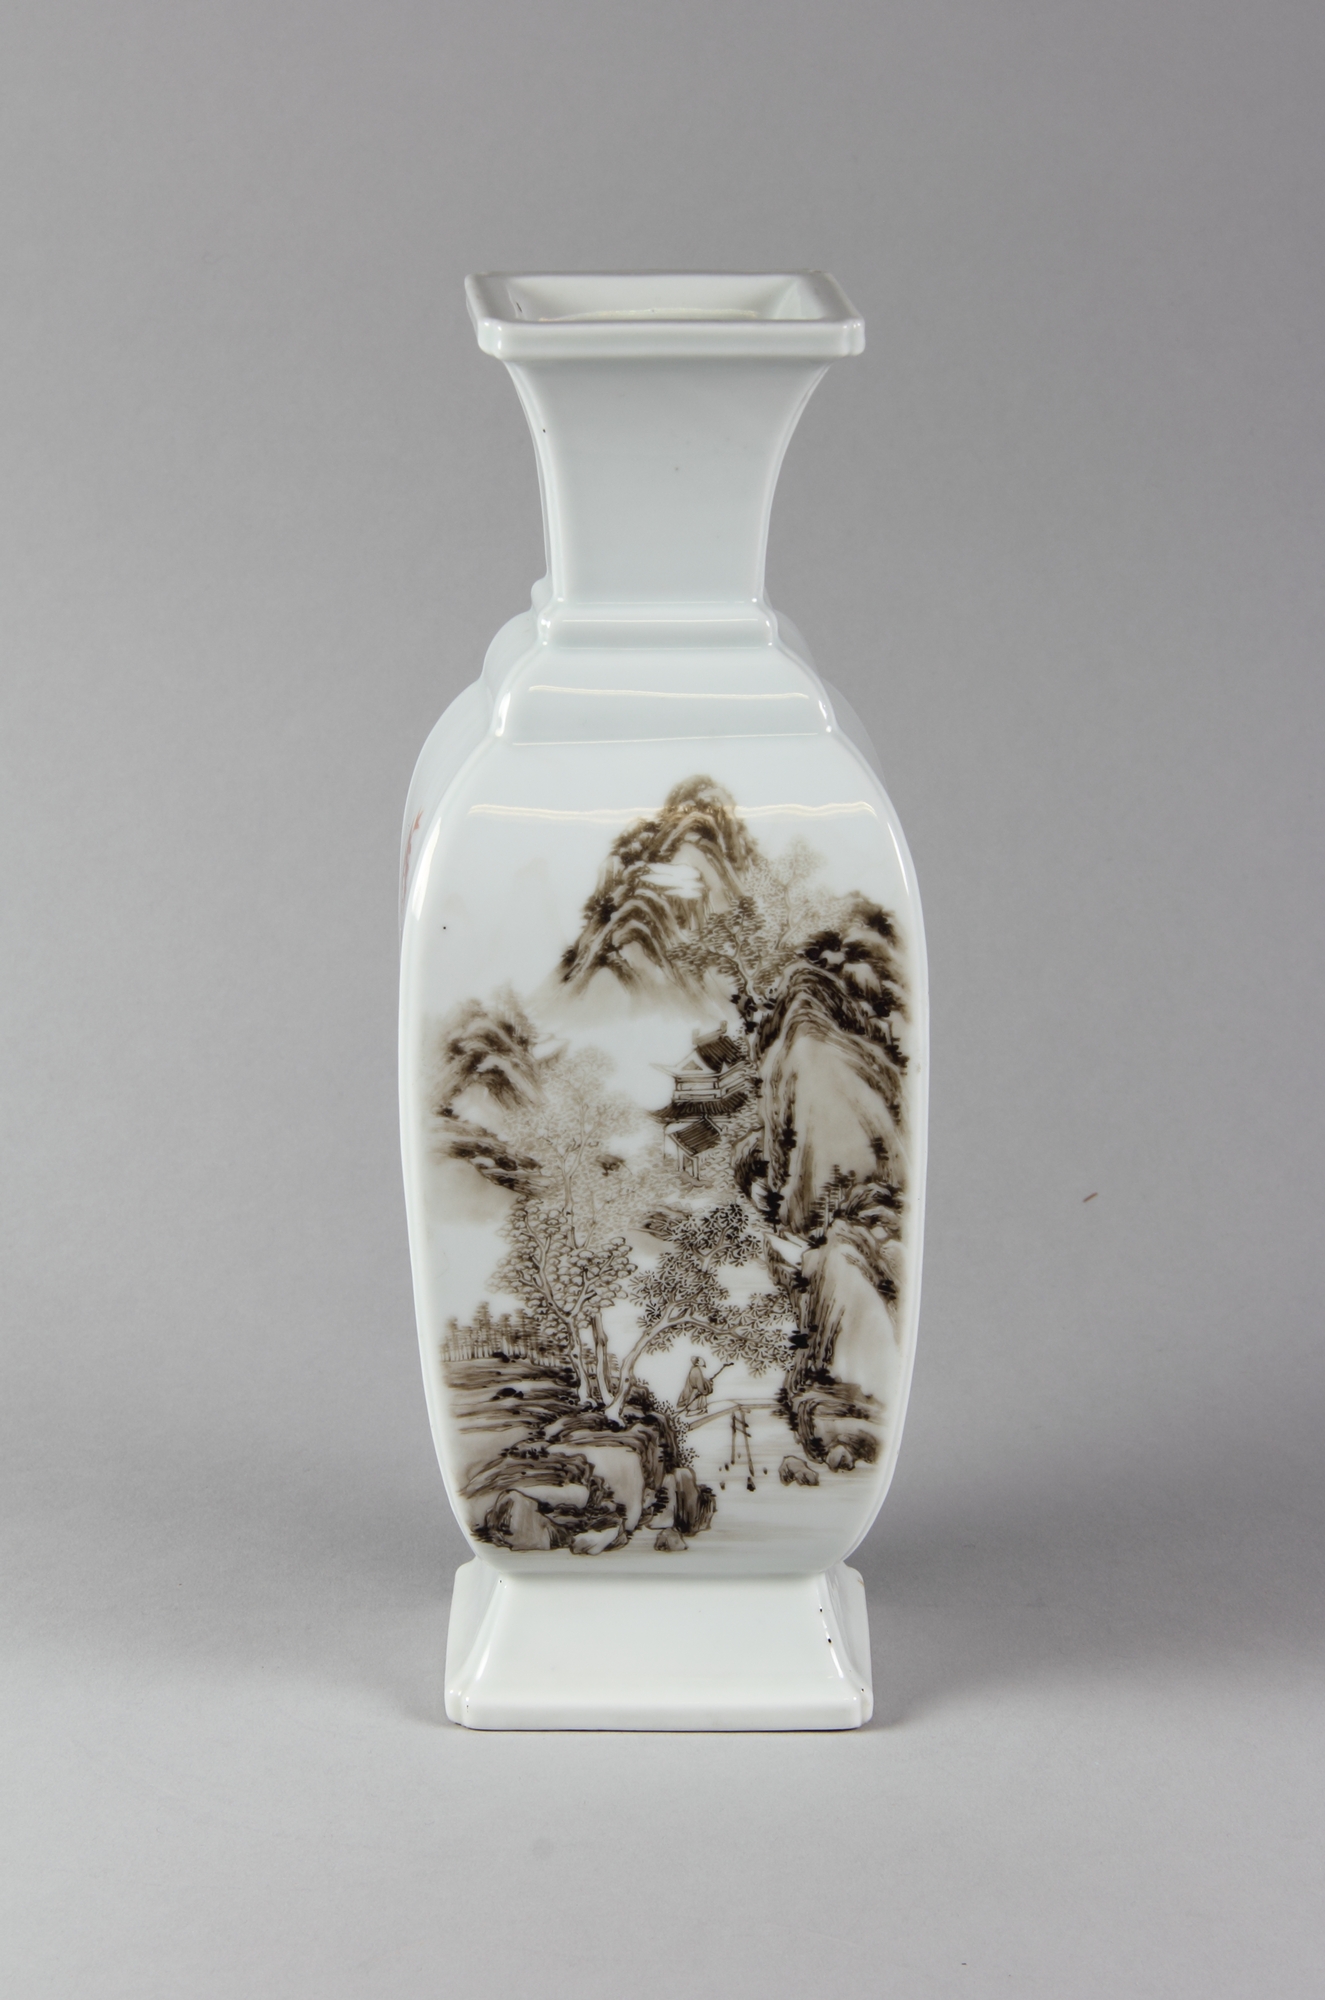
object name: vase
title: Vase with landscape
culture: chinese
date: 1701-1733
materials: enamel, porcelain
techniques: overglaze, painting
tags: human figures,houses,landscapes